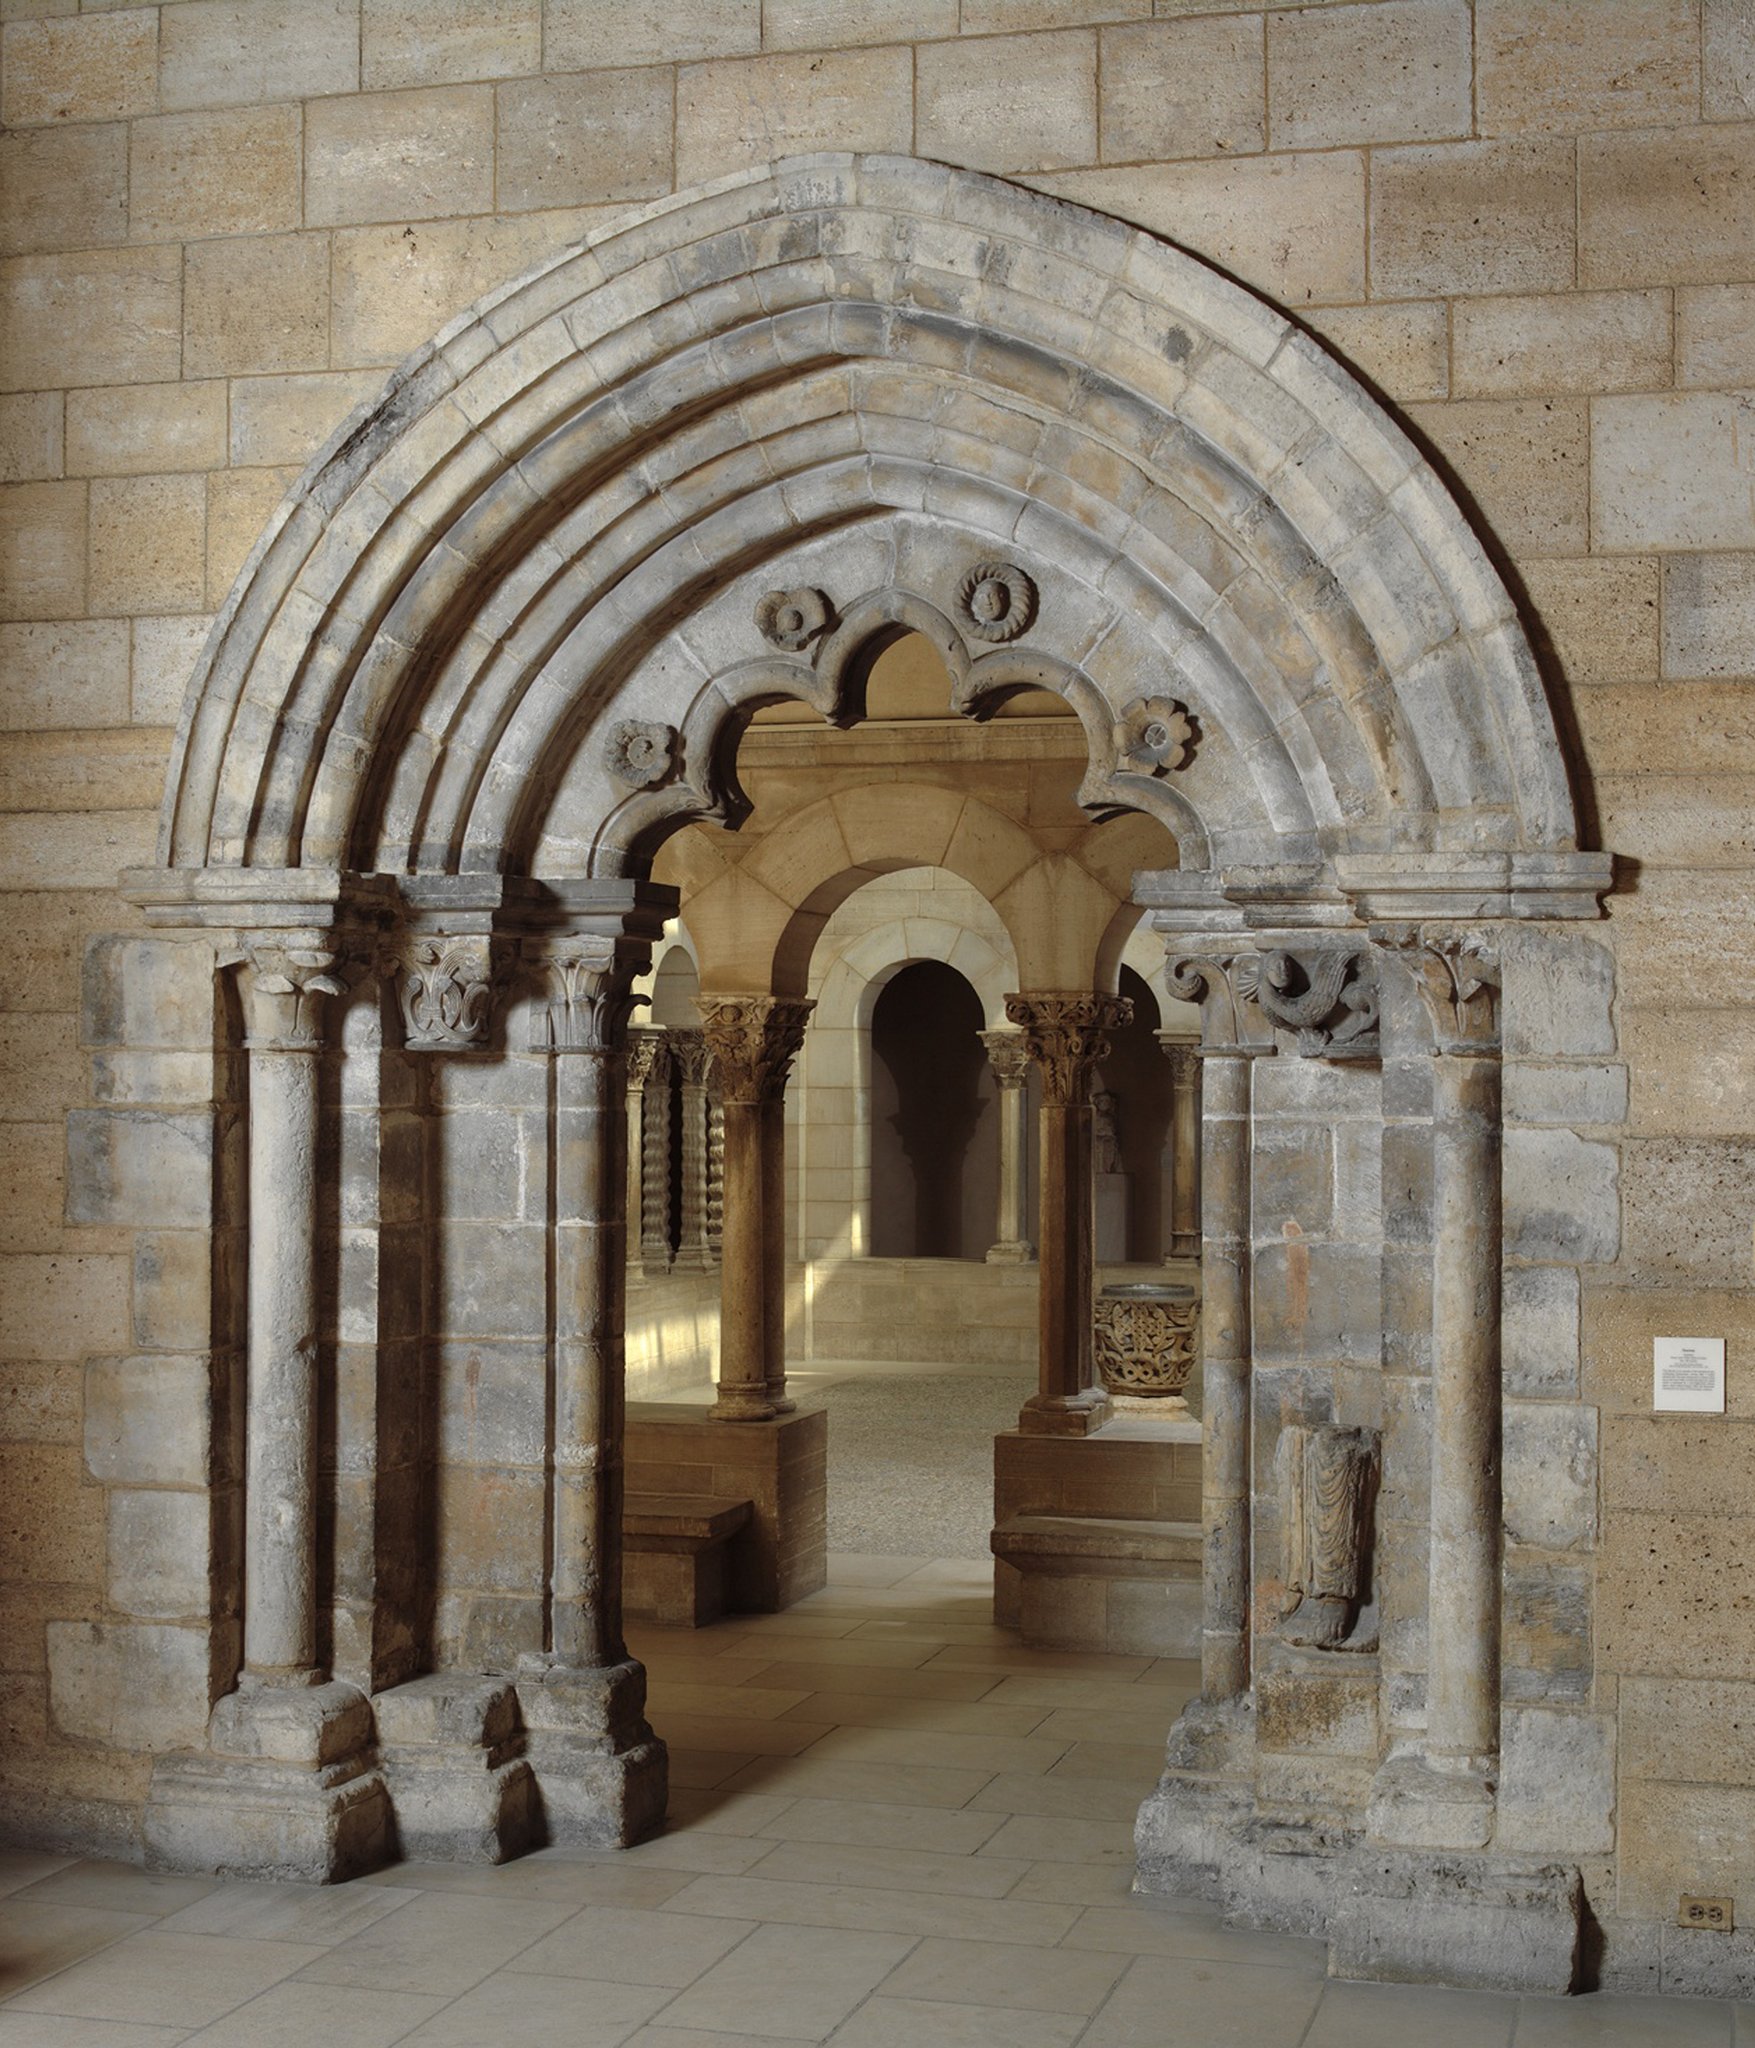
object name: doorway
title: Doorway from Notre-Dame at Reugny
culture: french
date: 1167-1200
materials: limestone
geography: france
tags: doorways